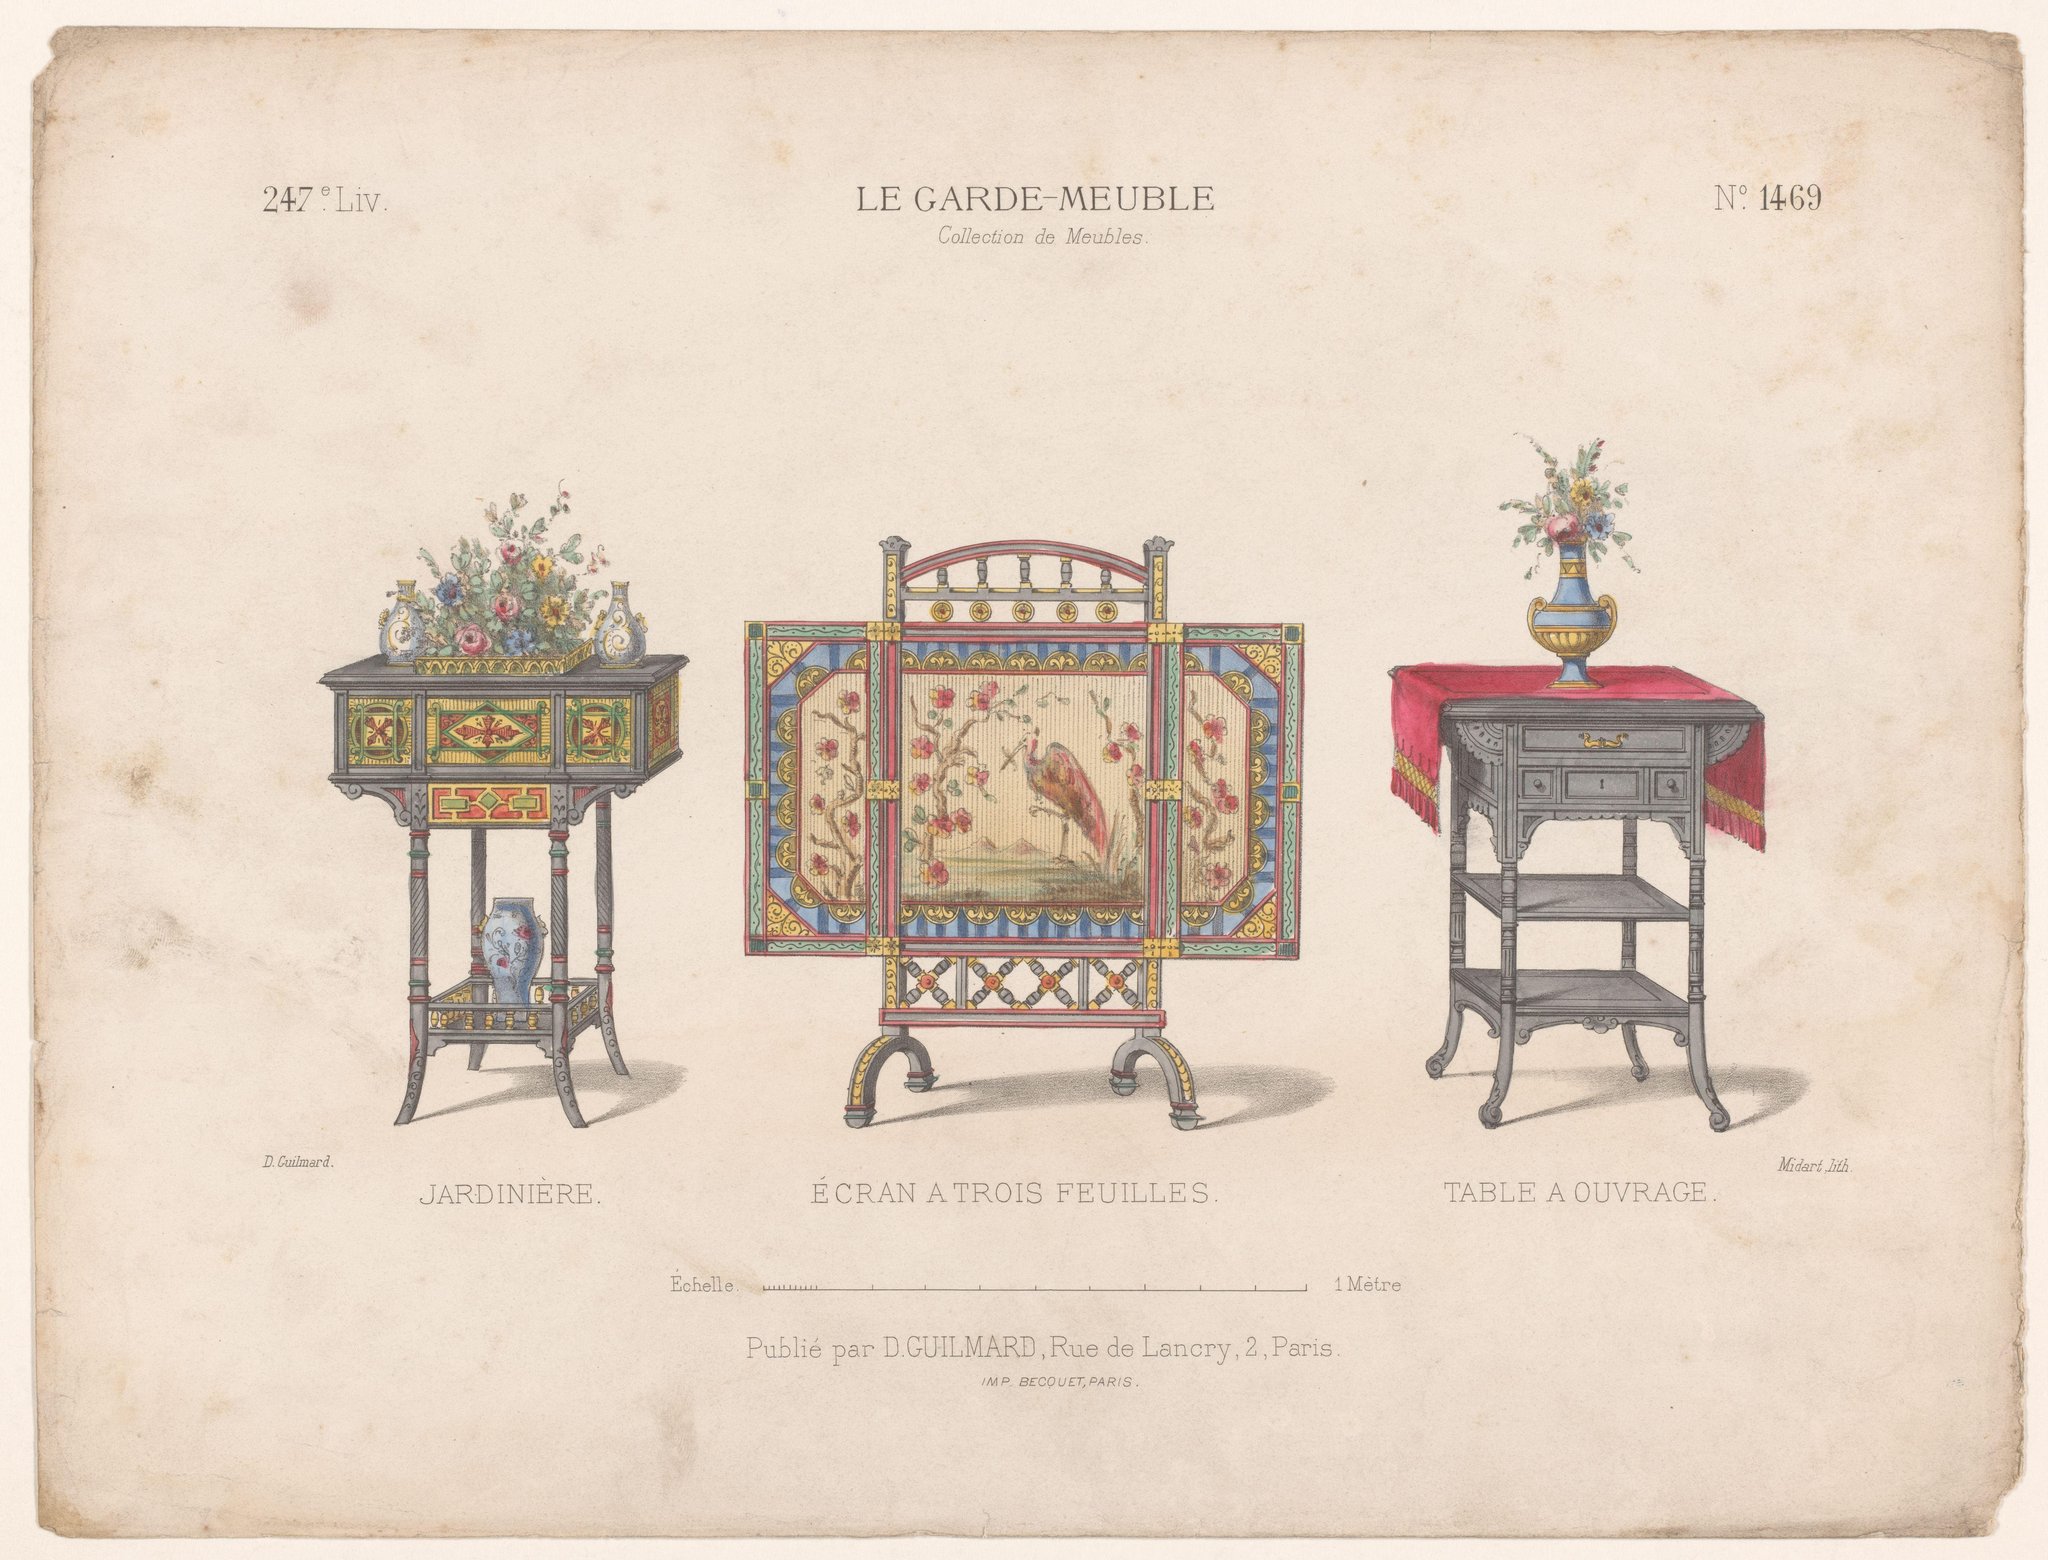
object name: print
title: Le garde-meuble / Collection de Meubles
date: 1839-1885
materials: paper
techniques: hand coloring, lithograph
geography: paris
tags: fire-screen, table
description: Ieder Livraison in de serie Le Garde-Meuble bevat negen platen: drie 'sièges' (zitmeubels), drie 'meubles' (diverse meubels zoals tafels en kasten) en drie 'tentures' (gordijnen en draperieën).